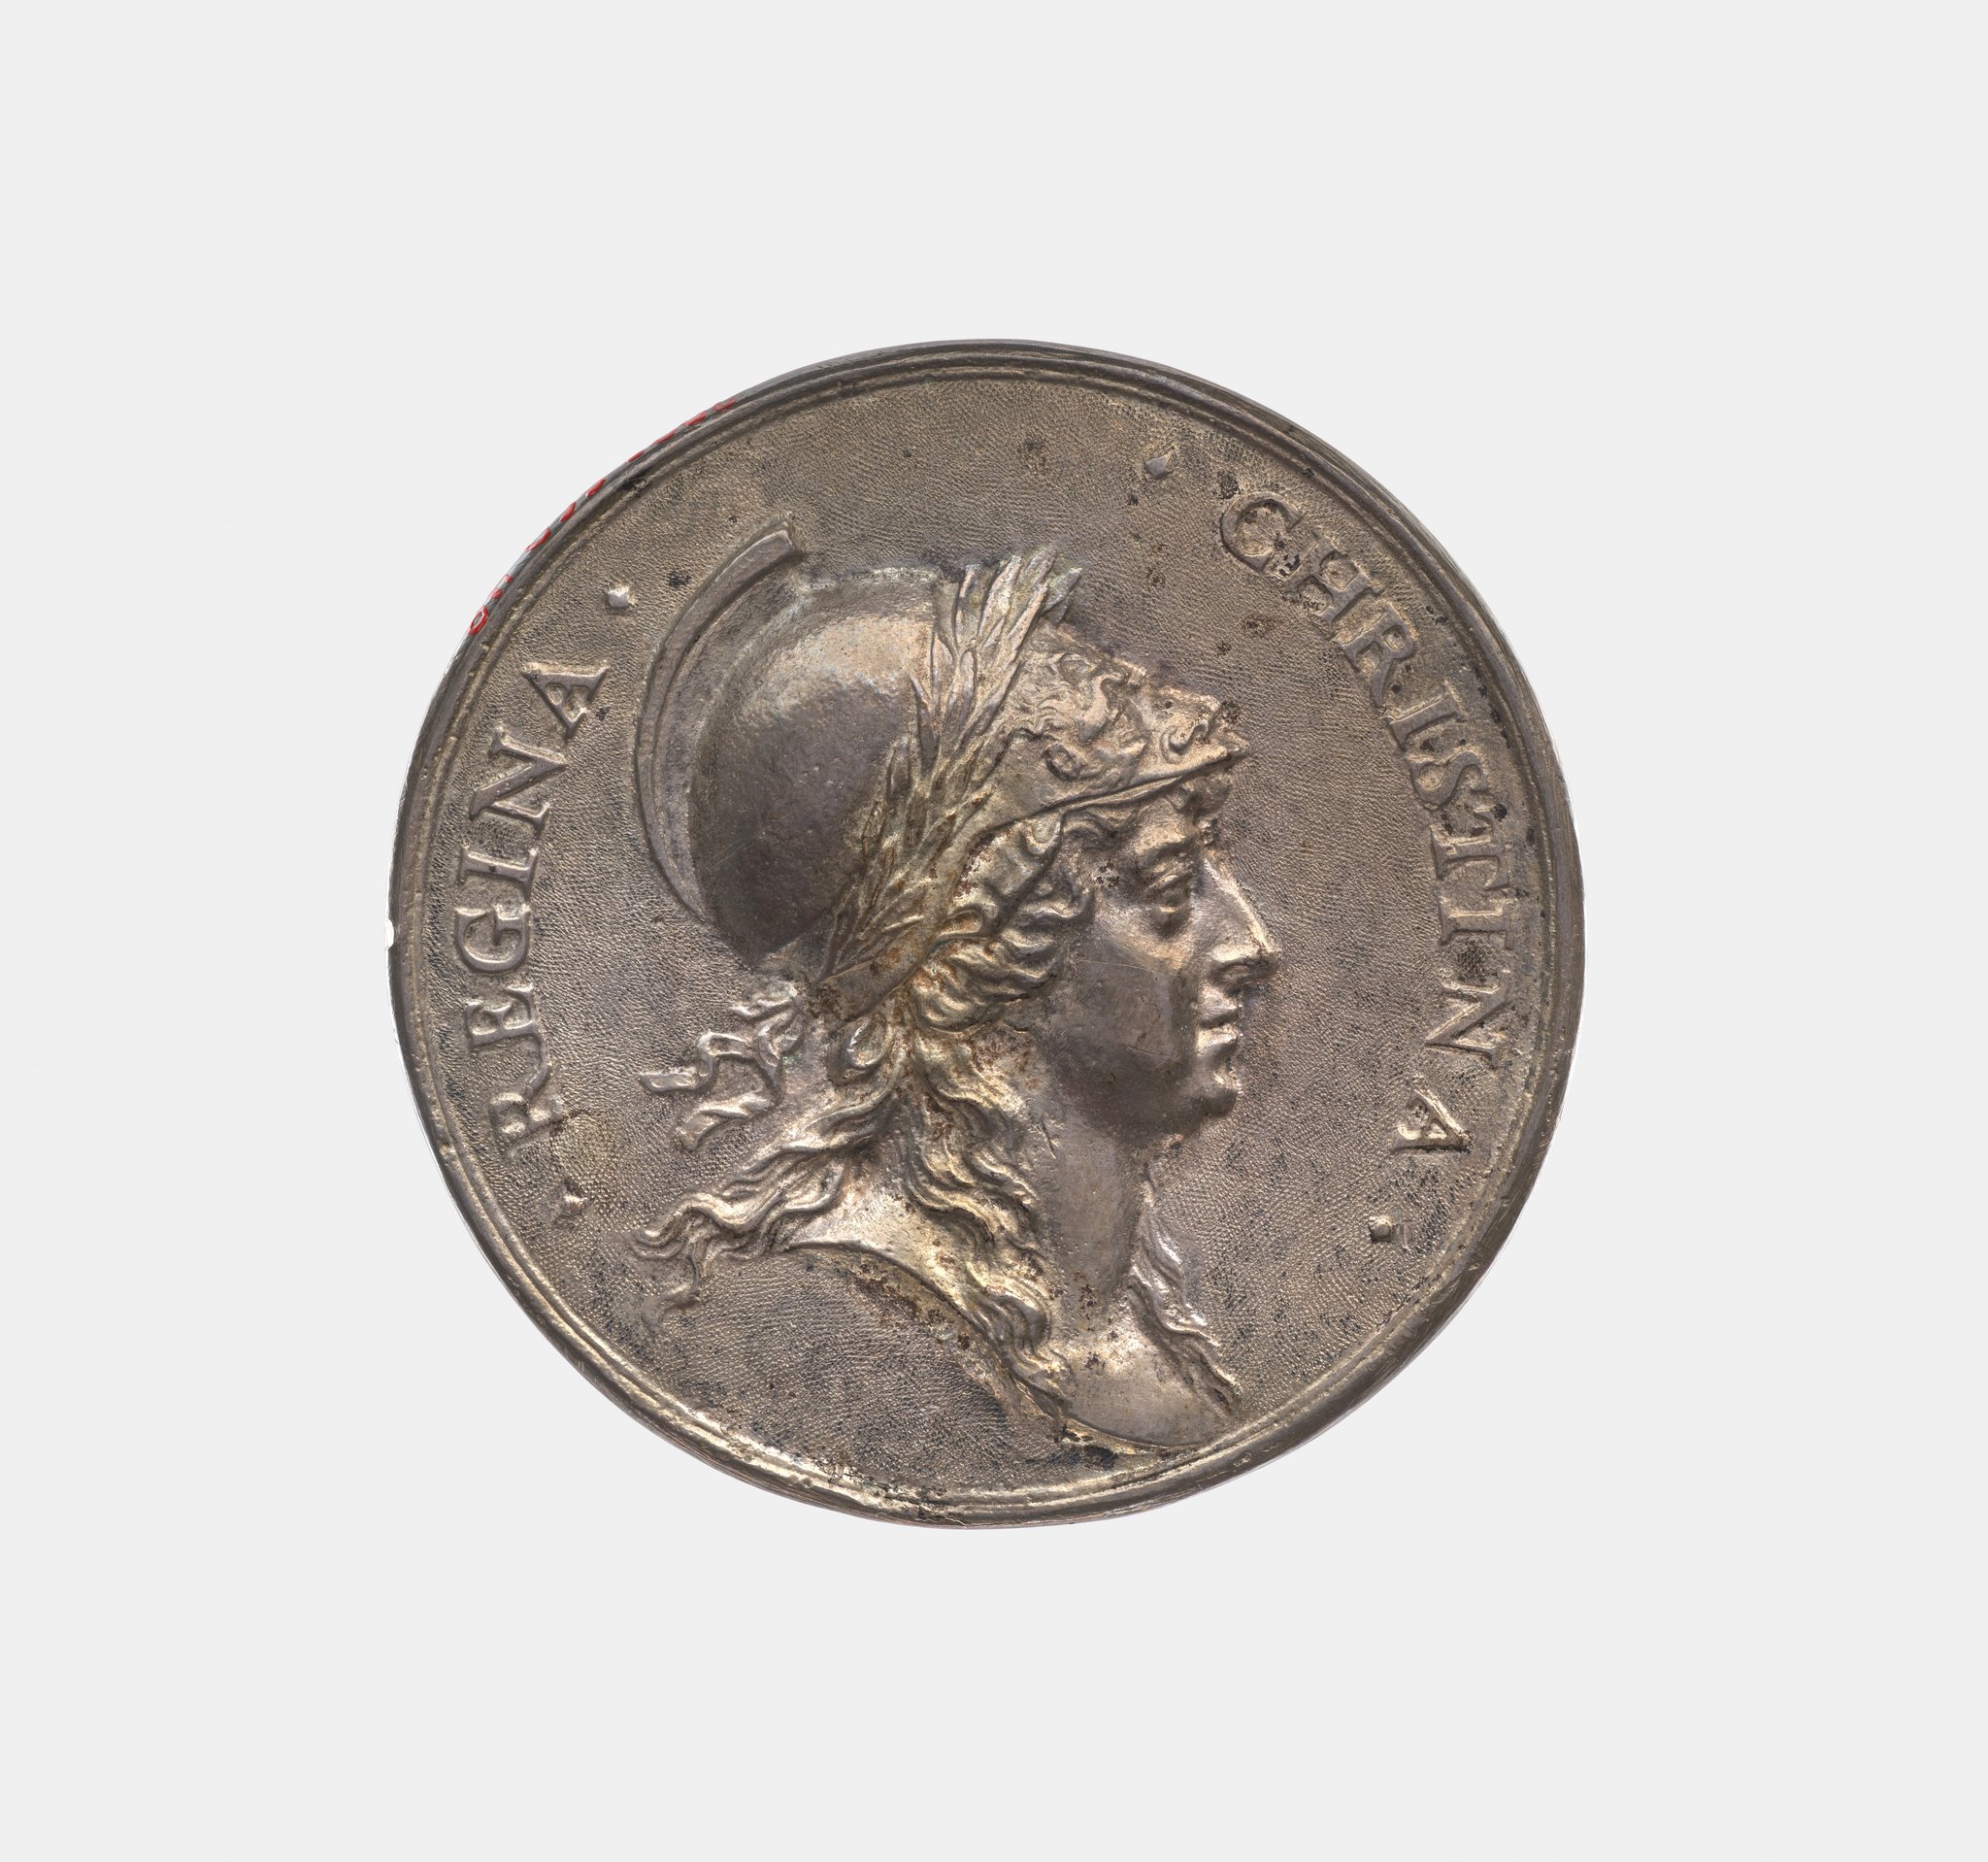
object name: medal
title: Christina 1626-89, Queen of Sweden 1632-54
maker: gioachino francesco travani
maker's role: artist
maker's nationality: italian, rome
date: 1665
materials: silver